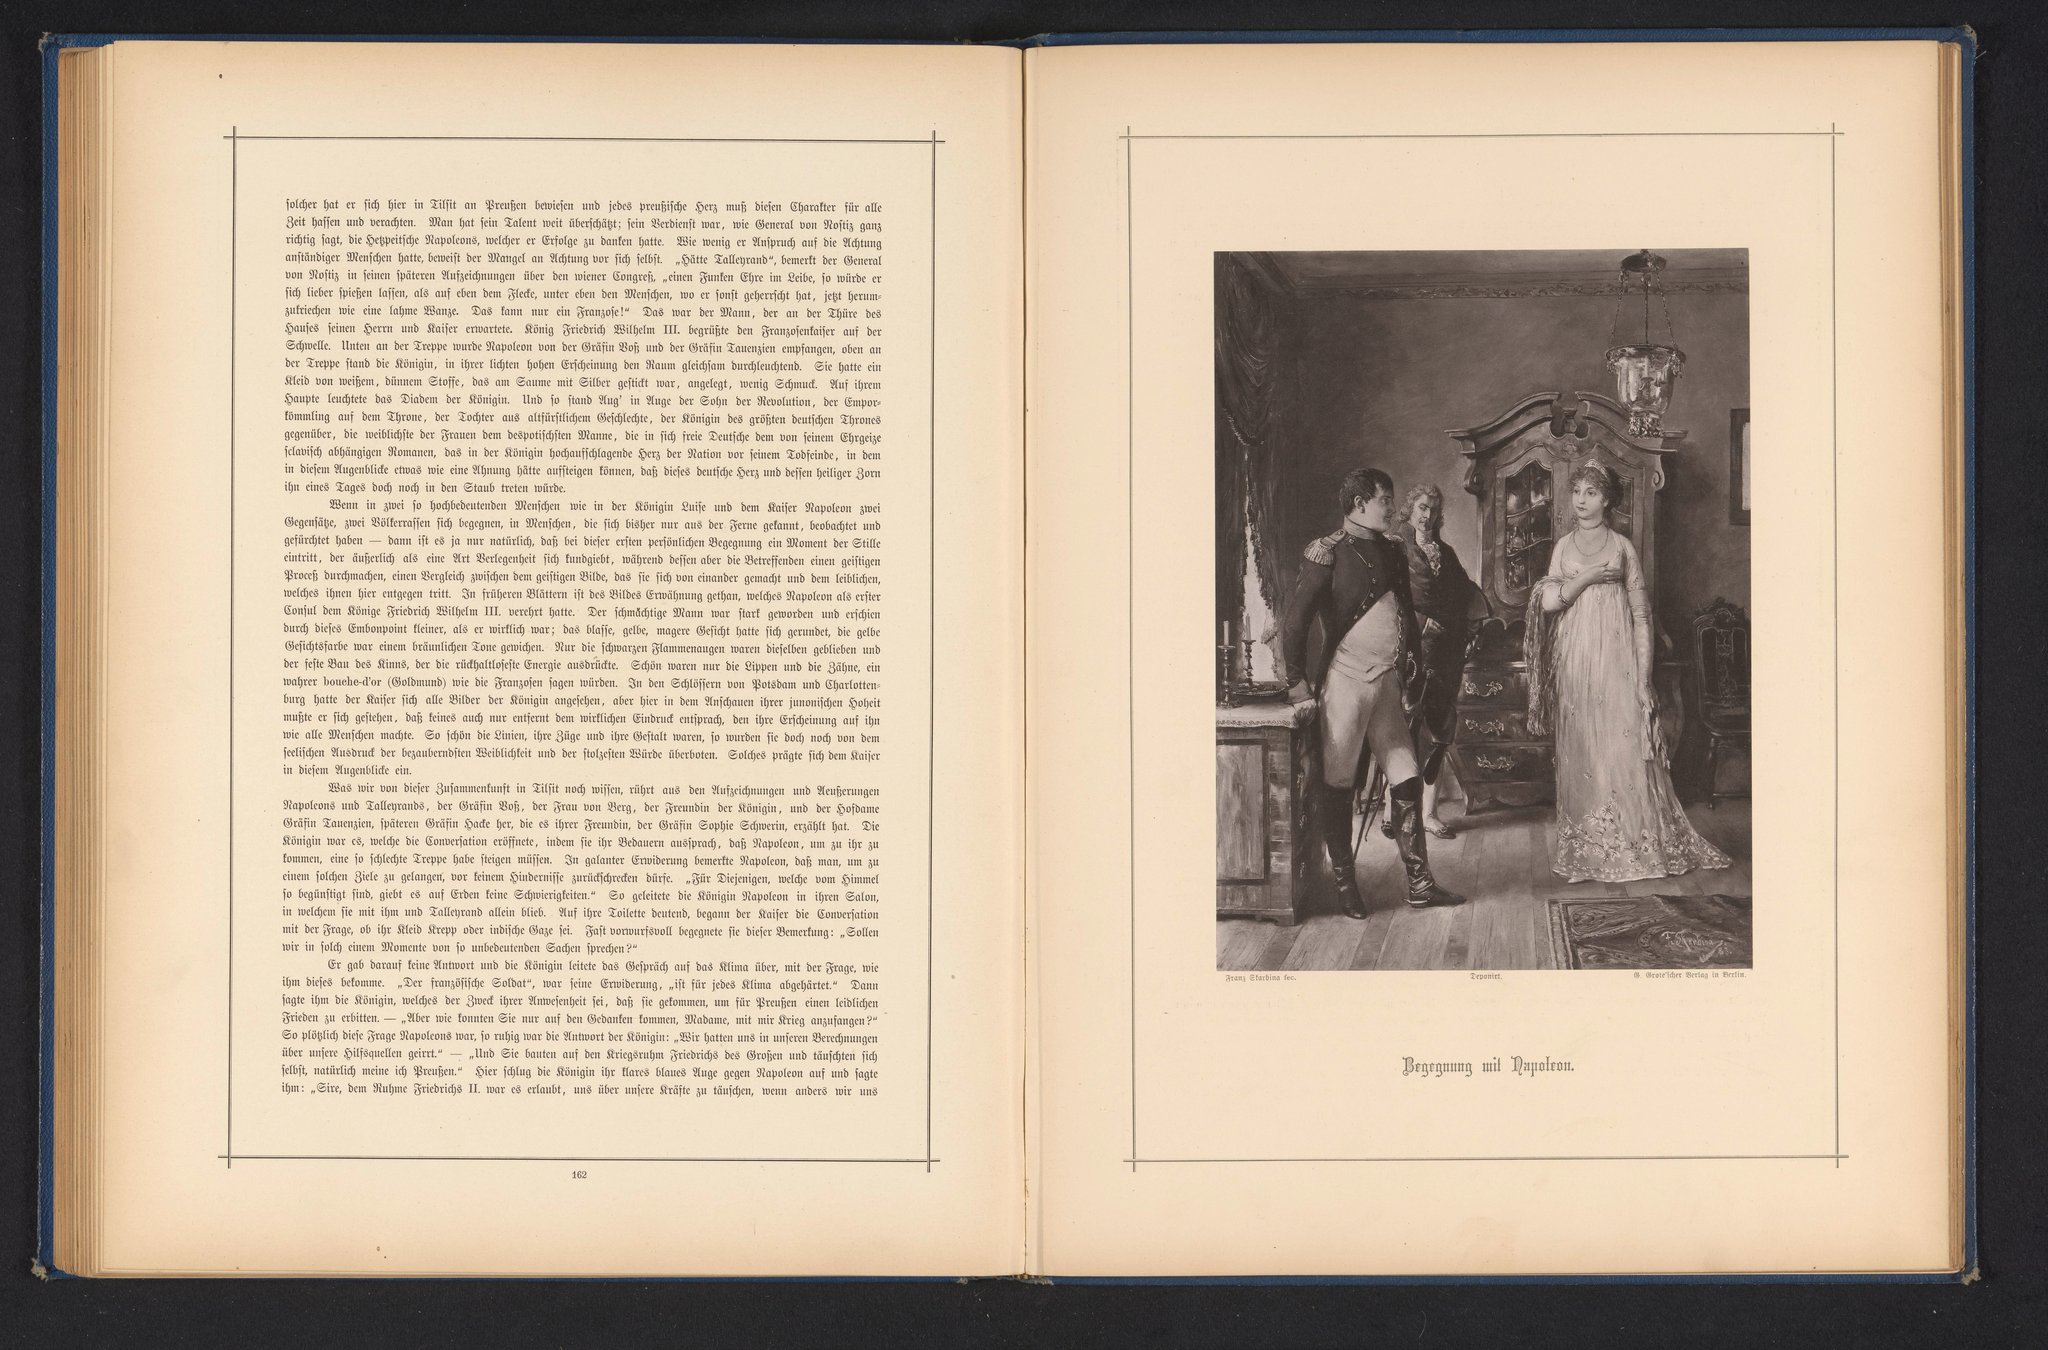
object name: page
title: Begegnung mit Napoleon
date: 1873-1883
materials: paper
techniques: photograph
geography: berlin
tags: napoleon i (emperor of the french), interior of the house, meeting